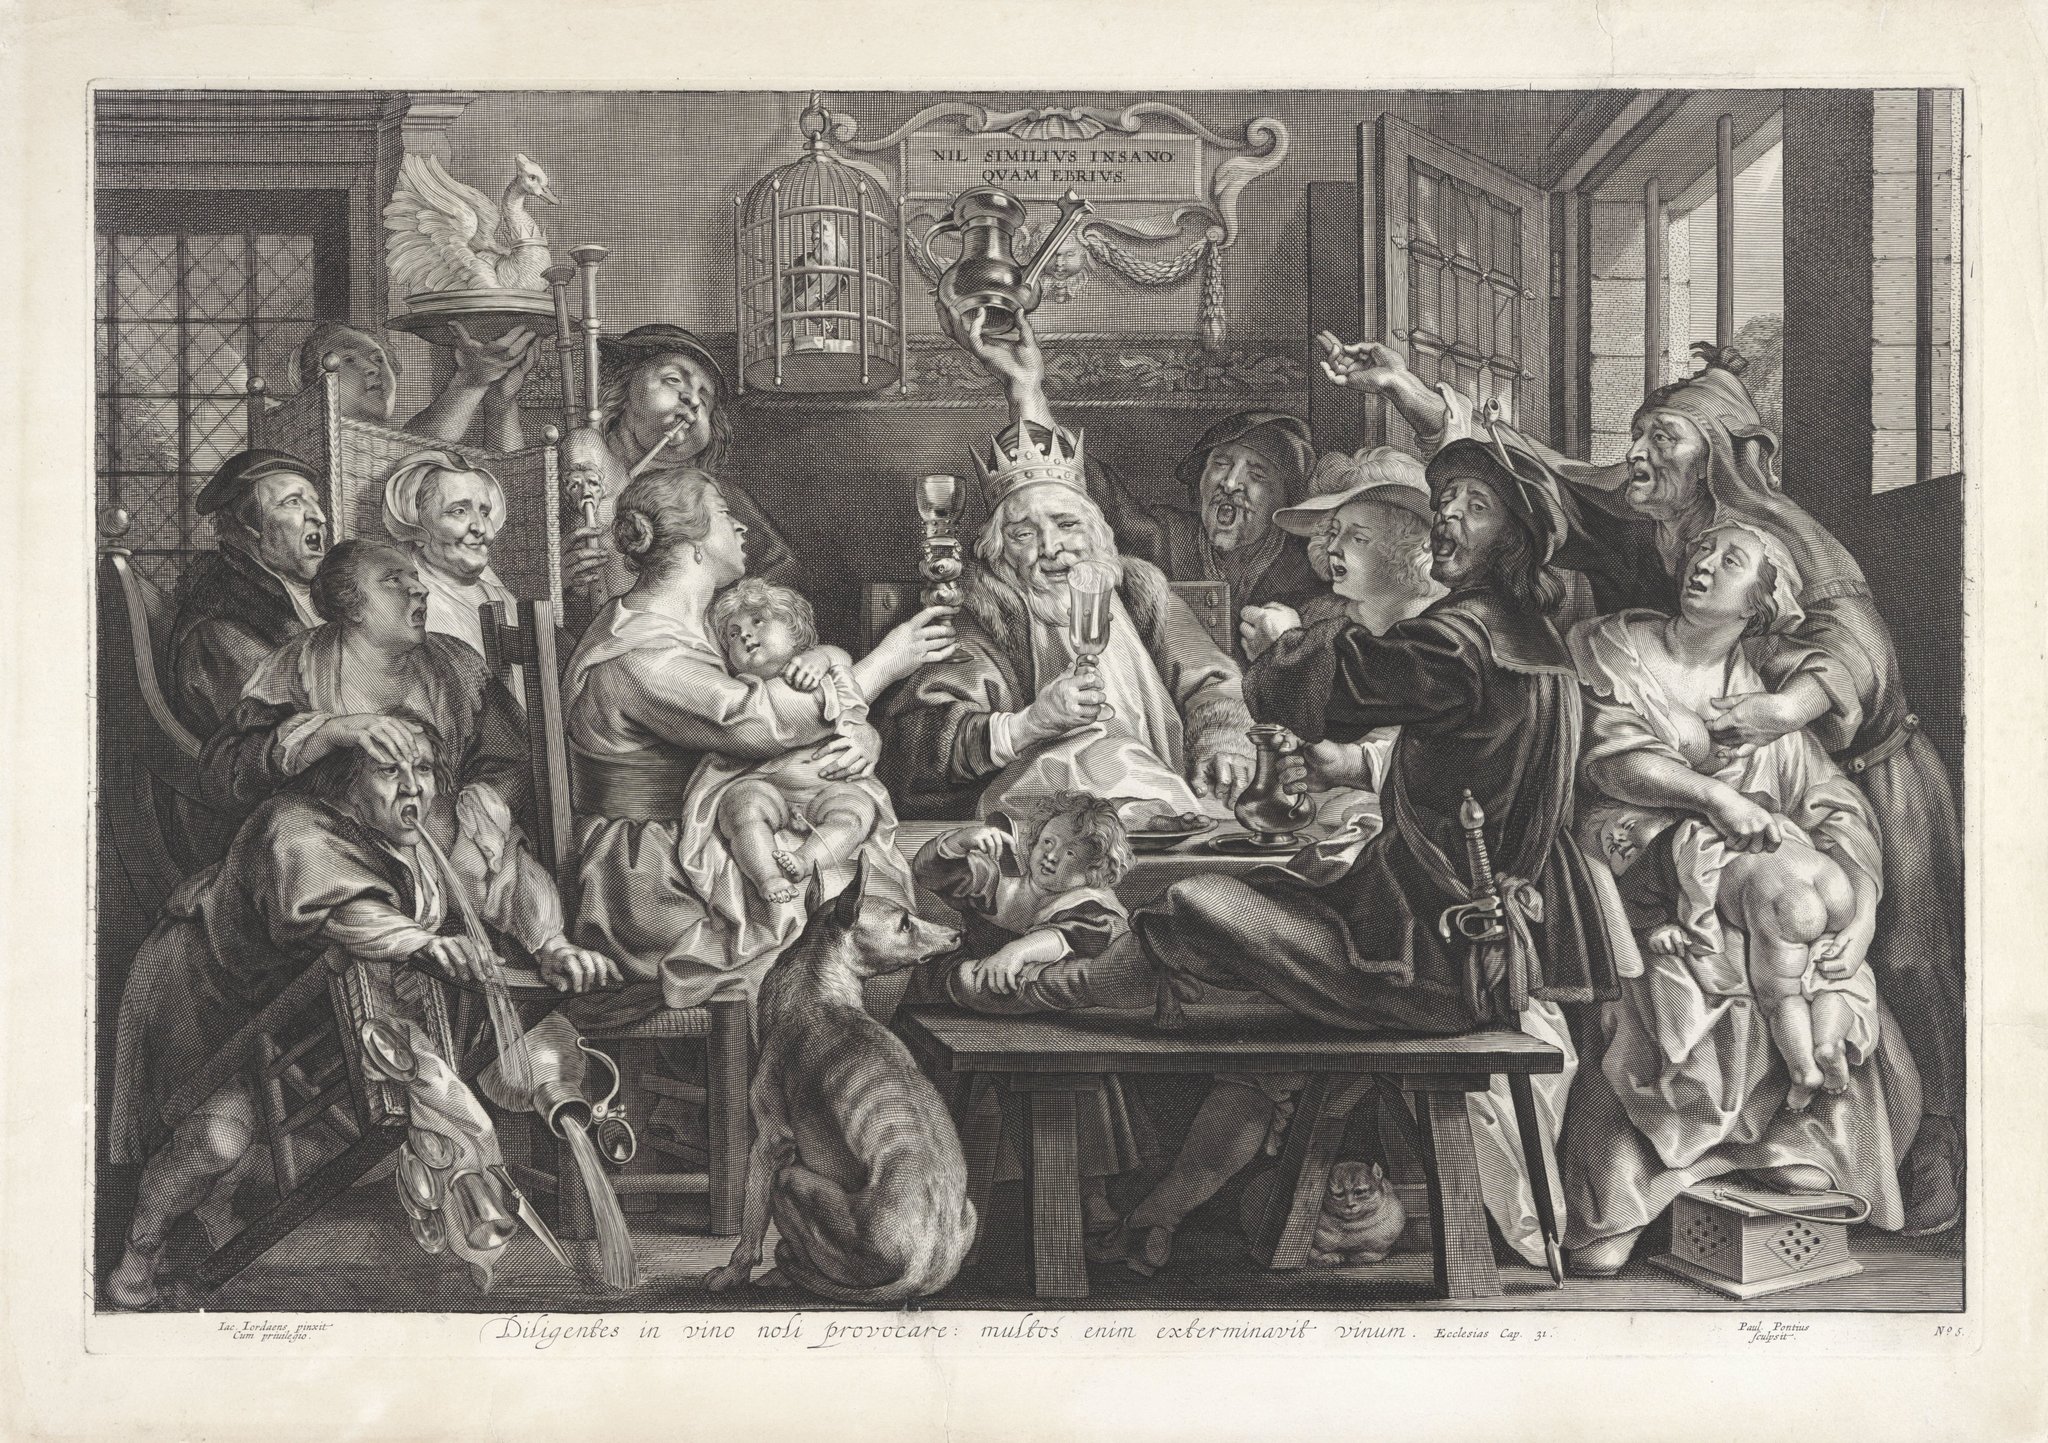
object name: print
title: De koning drinkt (Driekoningen)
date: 1616-1657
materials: paper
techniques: engraving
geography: antwerp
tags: ornamental birds: parrot, twelfth night, usually falling on the eve of january 6, woman-chaser, urination, drunken brawl (usually peasants fighting in an inn)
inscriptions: title: ‘NIL SIMILIUS INSANO QUAM EBRIUS’, inscription: ‘Diligentes in vino noli provocare: multos enim exterminavit vinum. Ecclesias Cap. 31.’, collector's mark: Lugt 2228, signature: ‘Iac. Iordaens pinxit / Cum privilegio’, signature: ‘Paul. Pontius / sculpsit’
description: In een vertrek viert een uitbundig gezelschap Driekoningen. Mannen, vrouwen en kinderen eten, drinken en zingen. In het midden heft de 'koning', een dikke man met papieren koningskroon op het hoofd, zijn glas. Boven zijn hoofd aan de muur hangt een tablet: Nil Similius Insano Quam Ebrius (Niets lijkt meer op een dwaas dan een beschonkene). Daarnaast een papegaai in een vogelkooi. Rechts veegt een vrouw de billen van een kind, terwijl een oude man haar borst grijpt. Vanaf de schoot van zijn moeder plast een kind op een hond die bij de tafel staat. Een man moet overgeven. In de marge een Bijbelcitaat uit Pr. 31 in het Latijn.